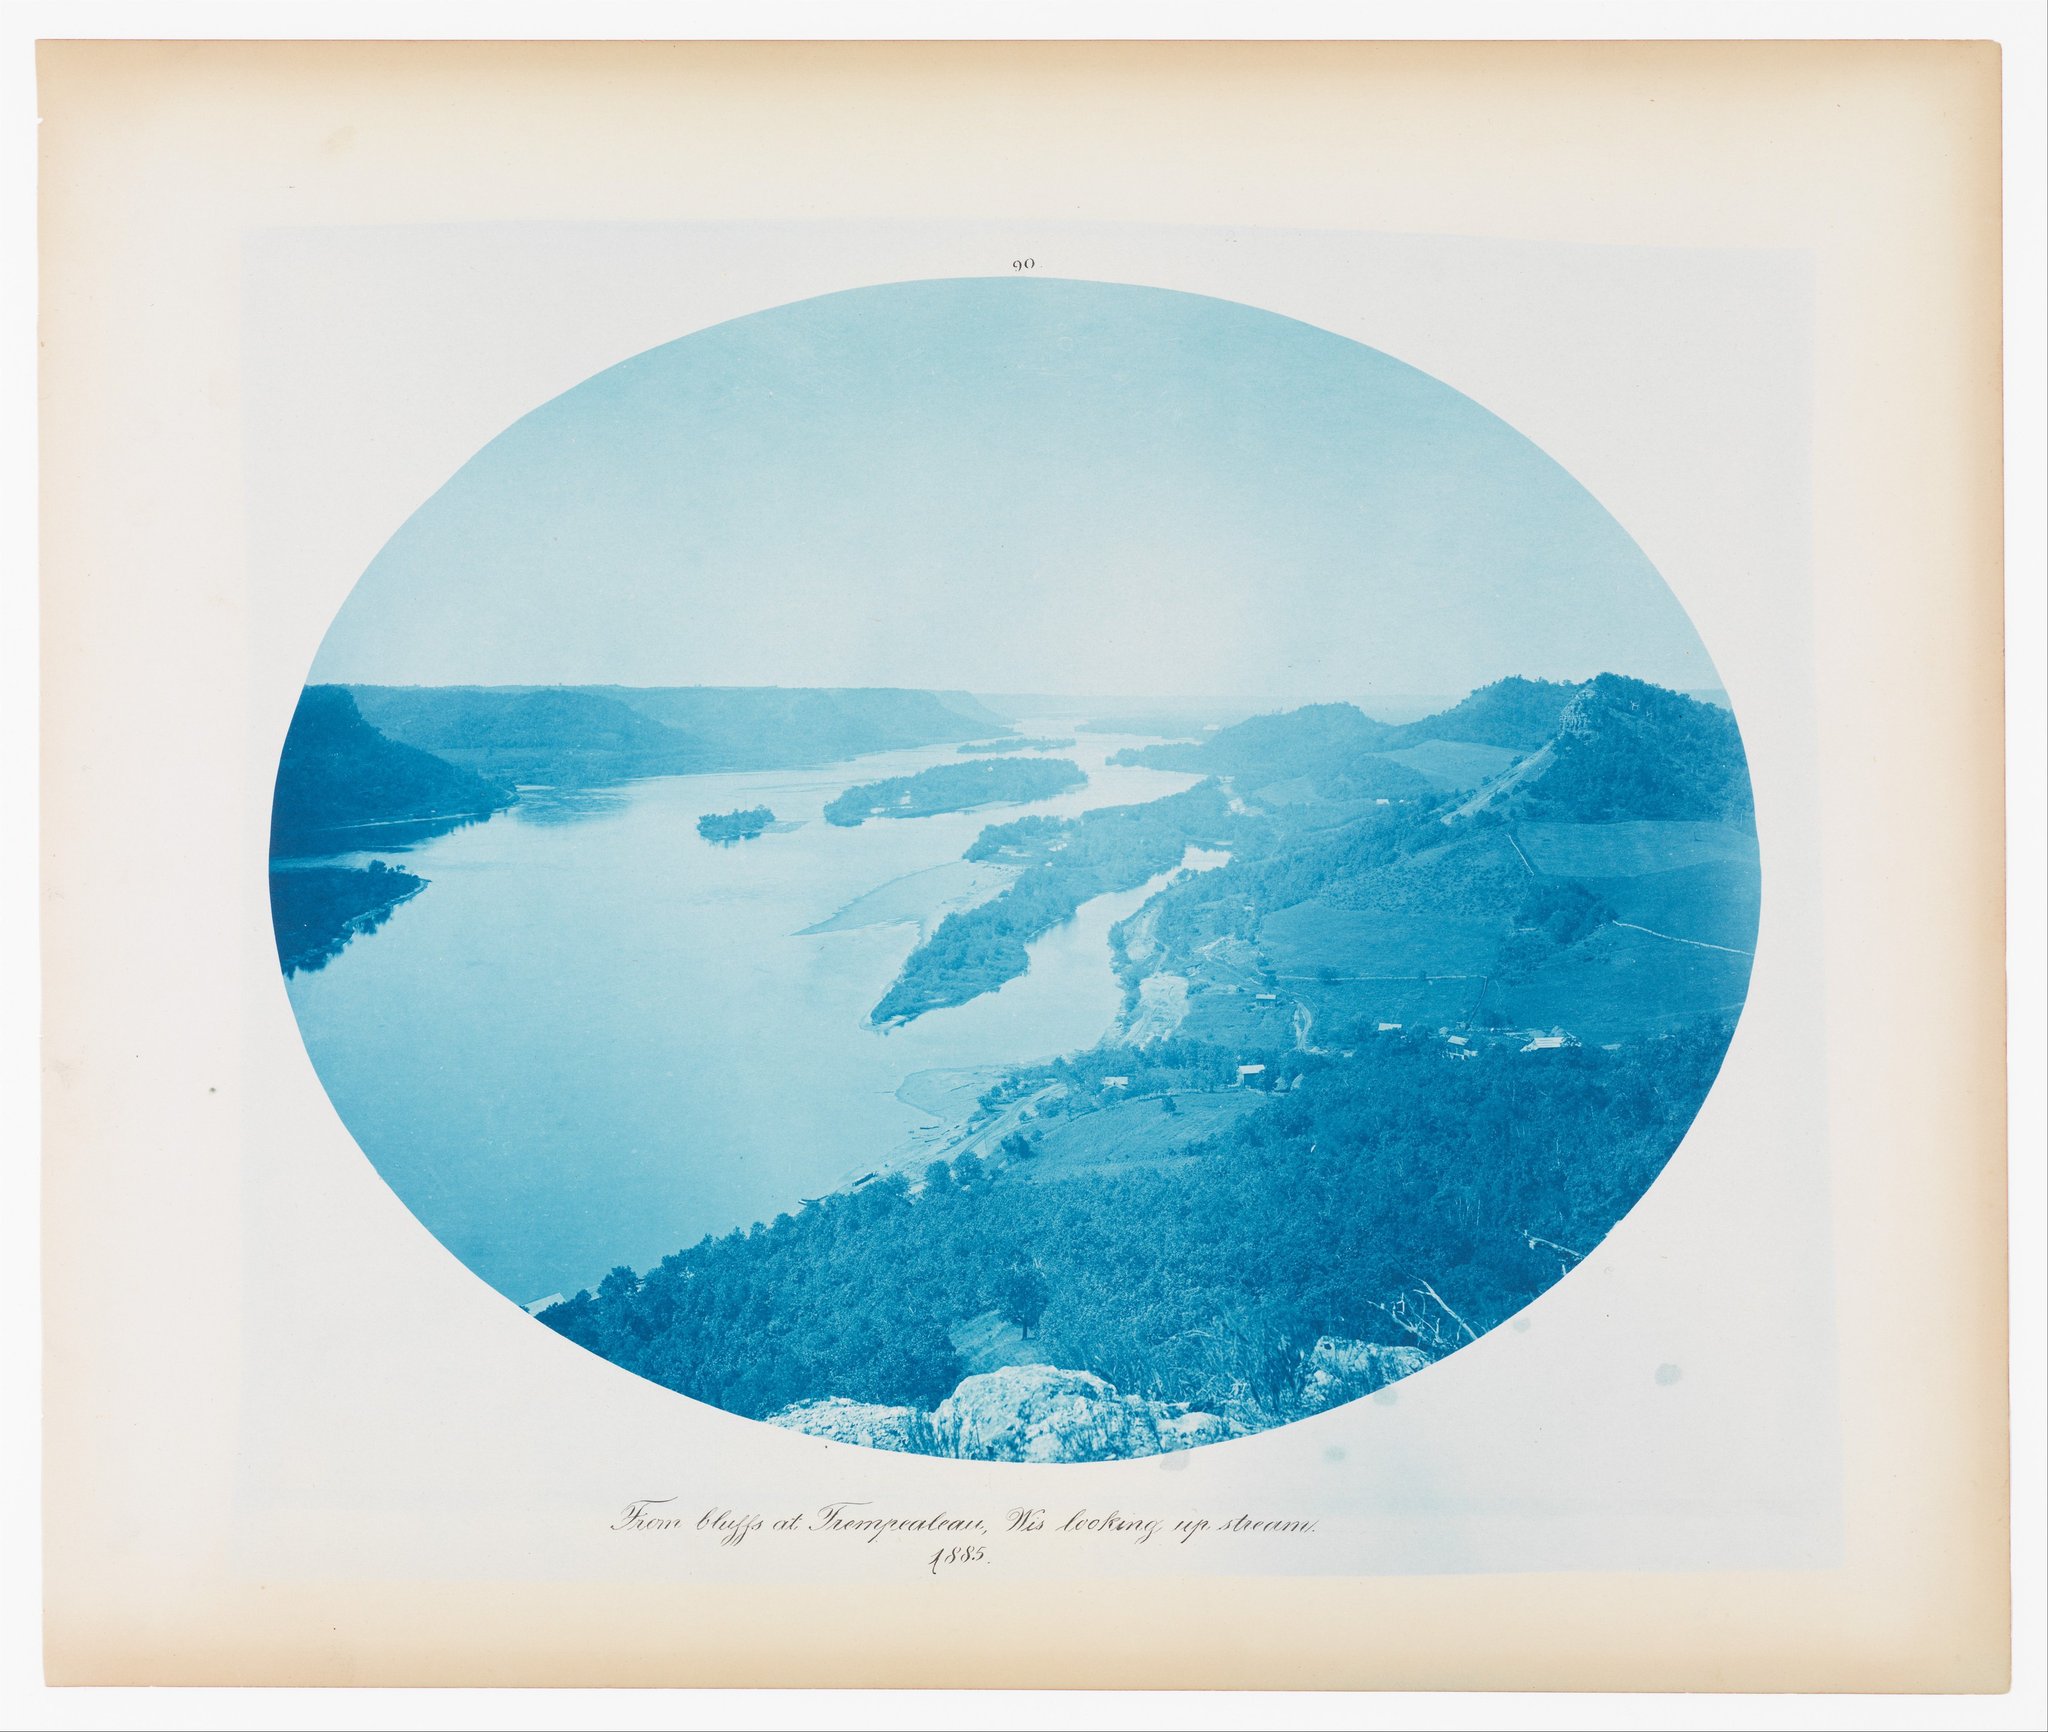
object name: photograph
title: No. 90. From bluffs at Trempealueau, Wisconsin Looking Up Stream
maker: henry p. bosse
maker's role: artist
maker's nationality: american, born germany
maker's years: 1844-1893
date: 1885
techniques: cyanotype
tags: landscapes